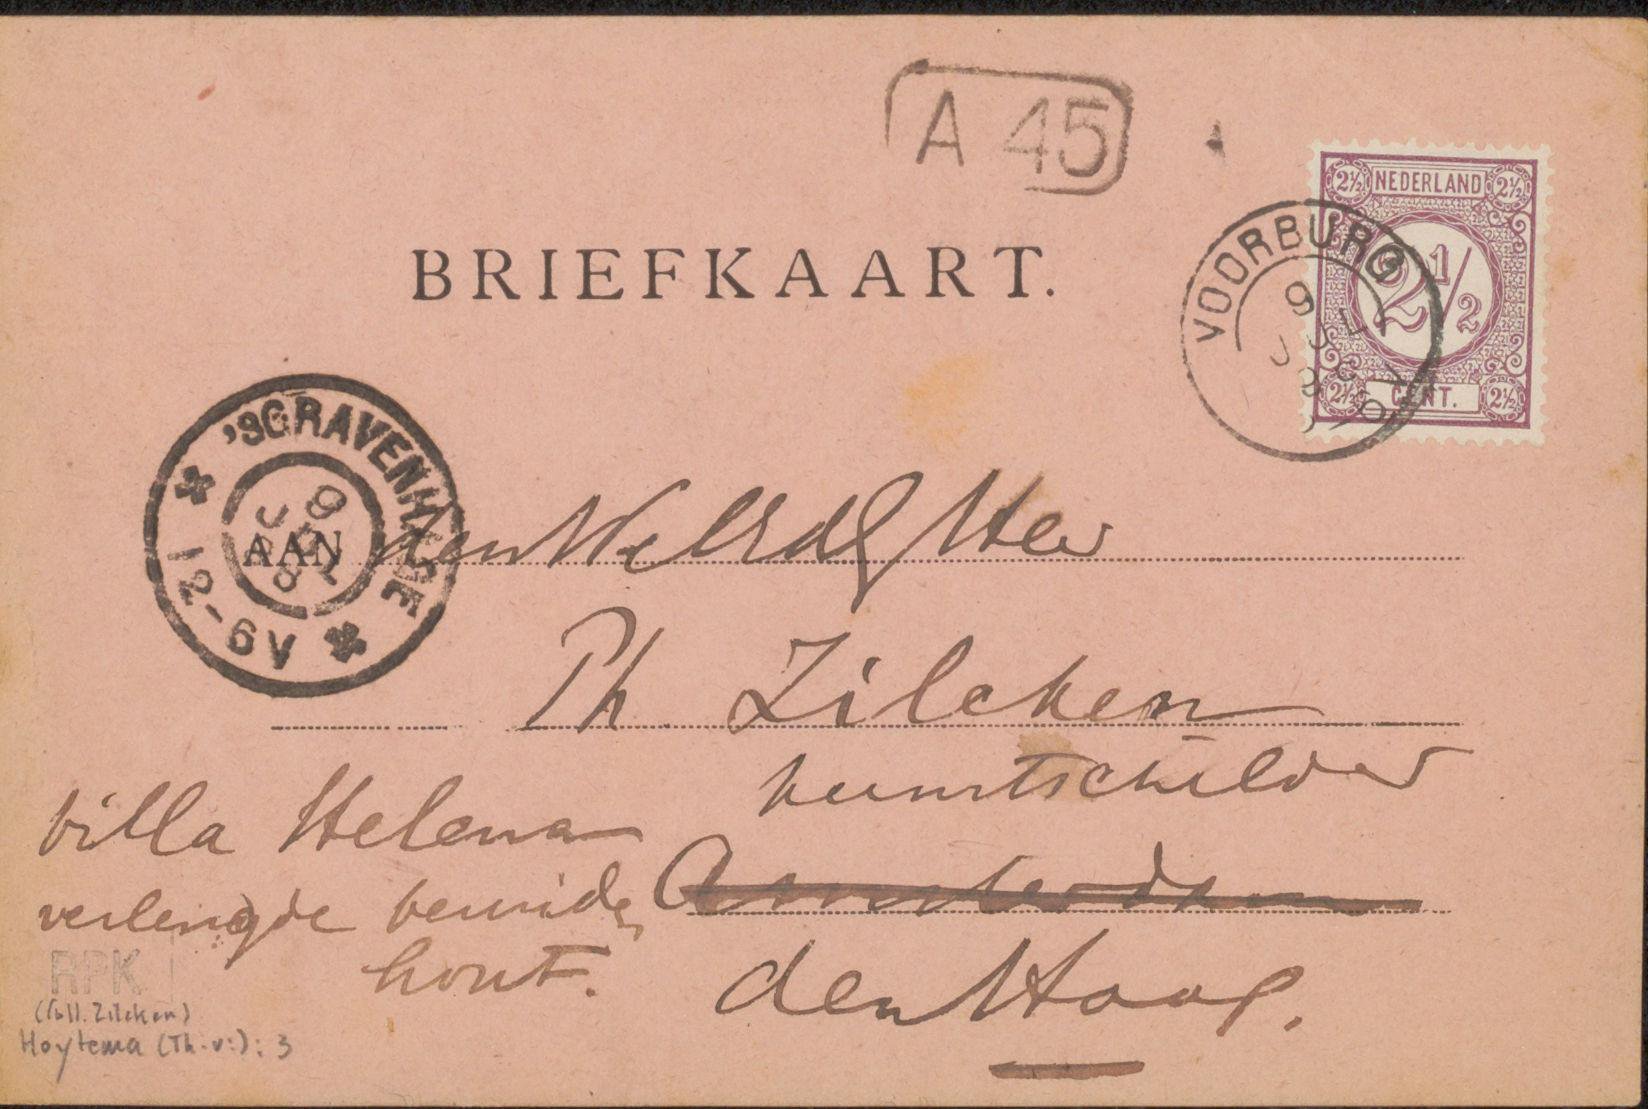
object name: postcard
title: Briefkaart aan Philip Zilcken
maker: theo van hoytema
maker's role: draughtsman, painter, print maker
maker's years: 1863-1917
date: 1896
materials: cardboard, ink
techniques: pen, writing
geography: voorburg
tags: philip zilcken, drawing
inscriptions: collector's mark: ‘RPK’